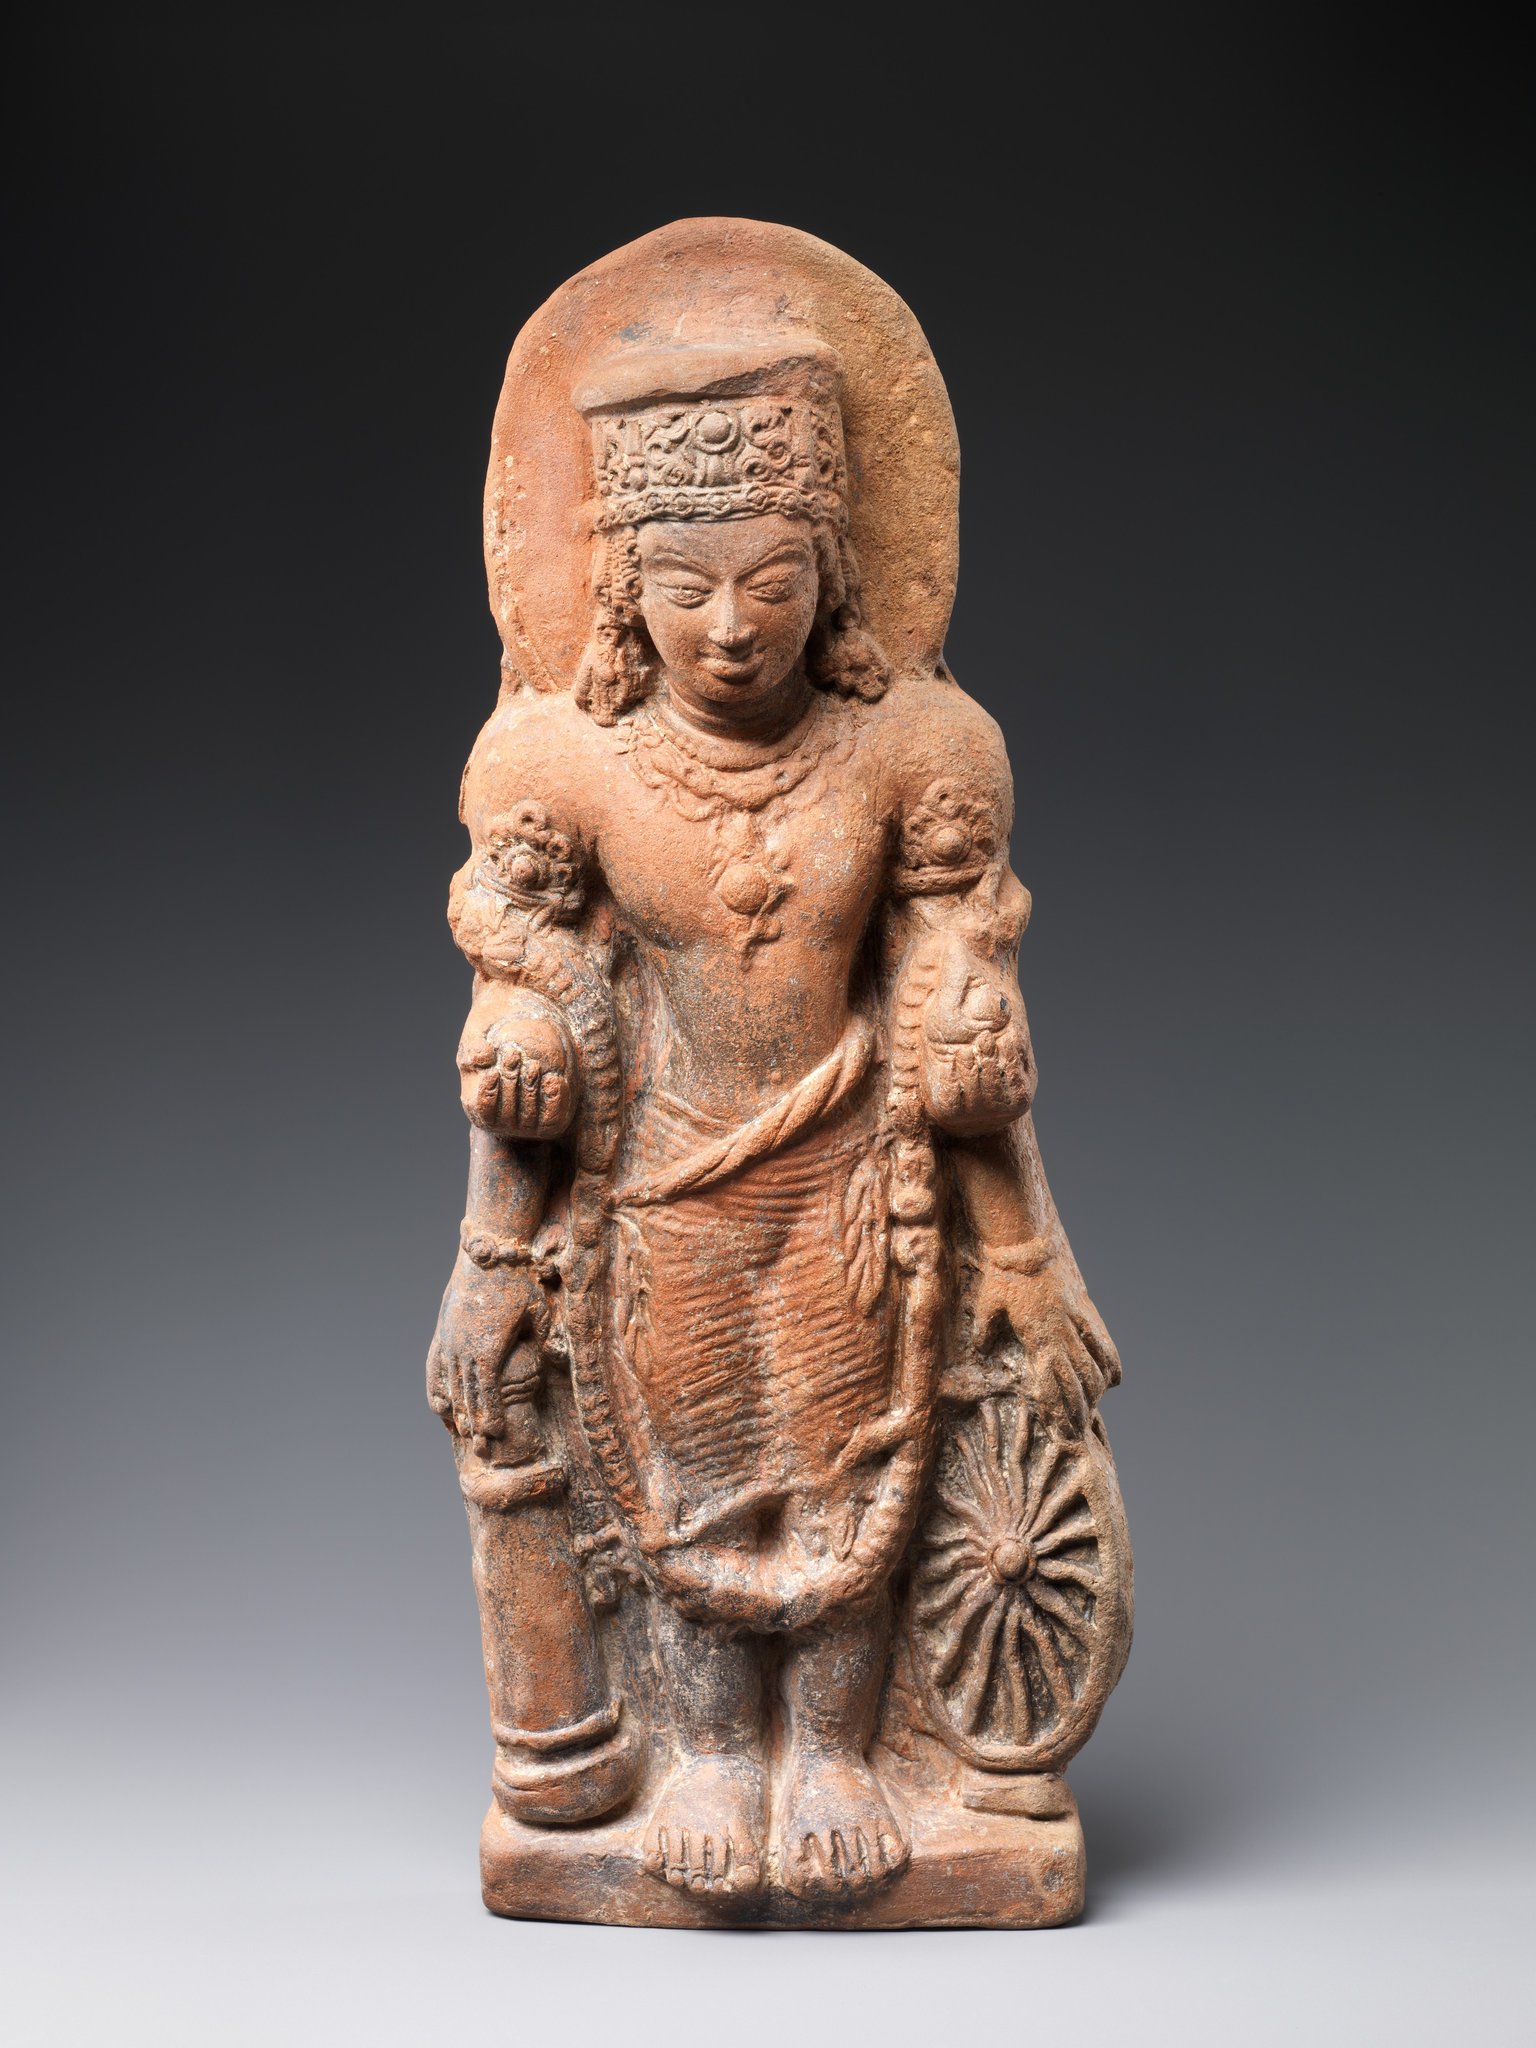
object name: figure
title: Standing Four-Armed Vishnu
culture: indian, uttar pradesh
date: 401-500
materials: terracotta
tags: gupta,vishnu